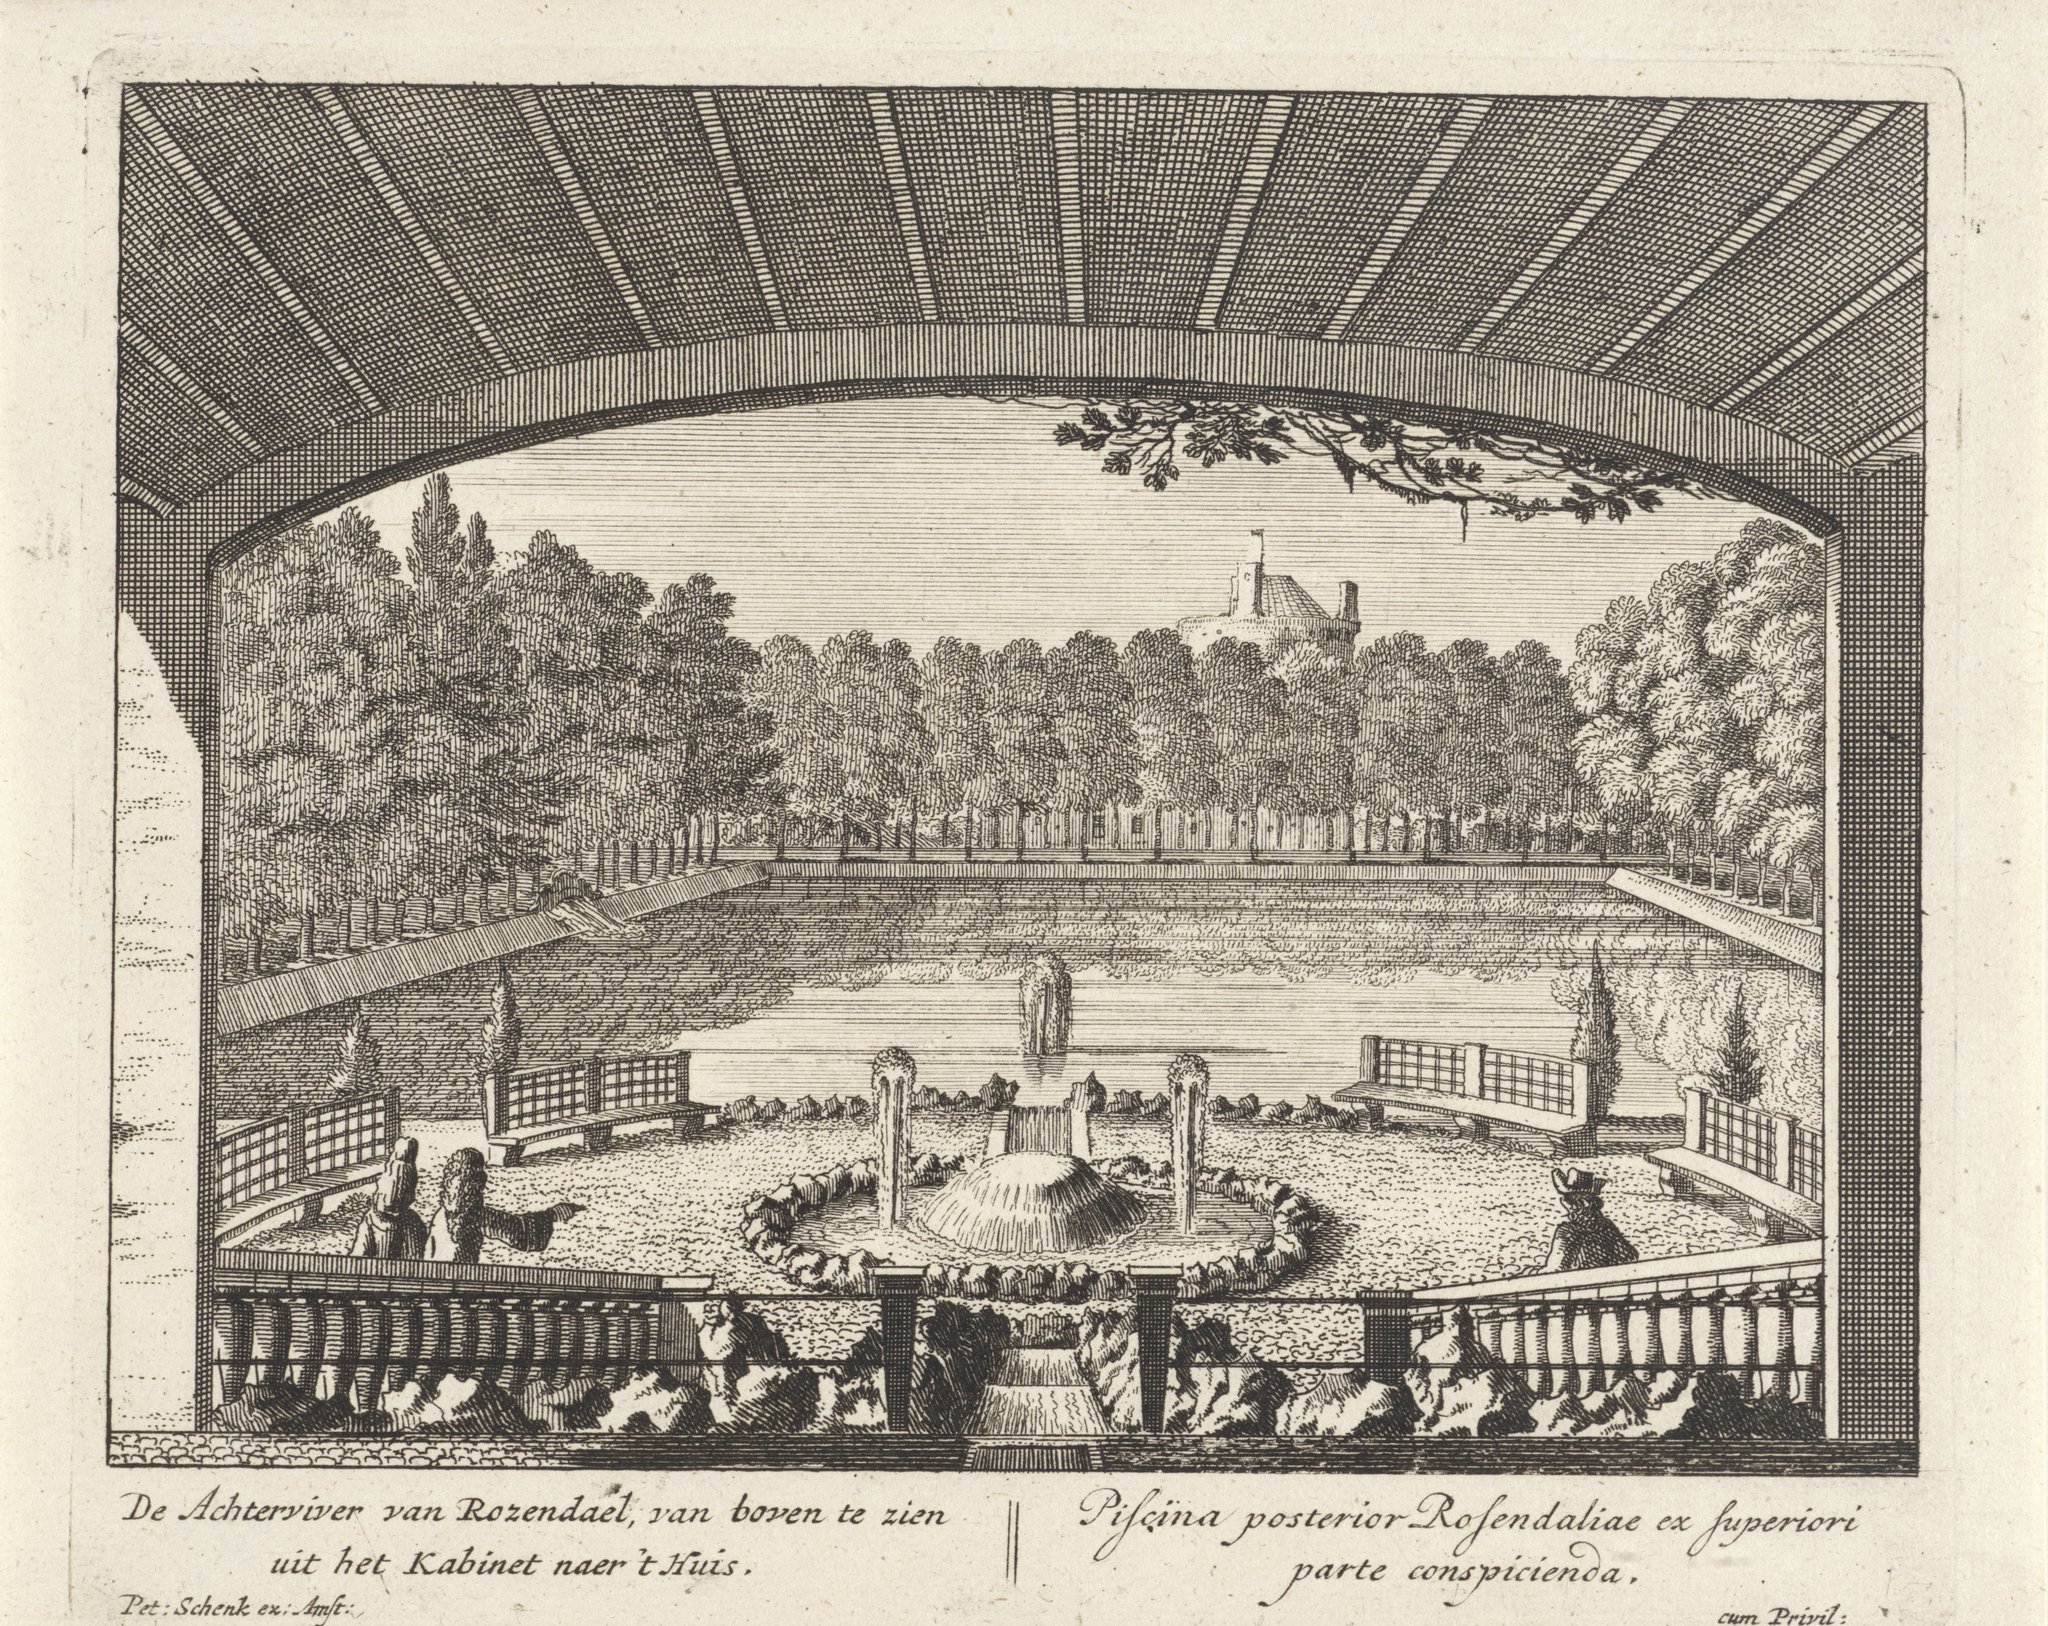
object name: print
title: Gezicht op de een grote vijver bij Kasteel Rosendael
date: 1675-1711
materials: paper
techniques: etching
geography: amsterdam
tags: garden pond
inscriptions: collector's mark: Lugt 2228